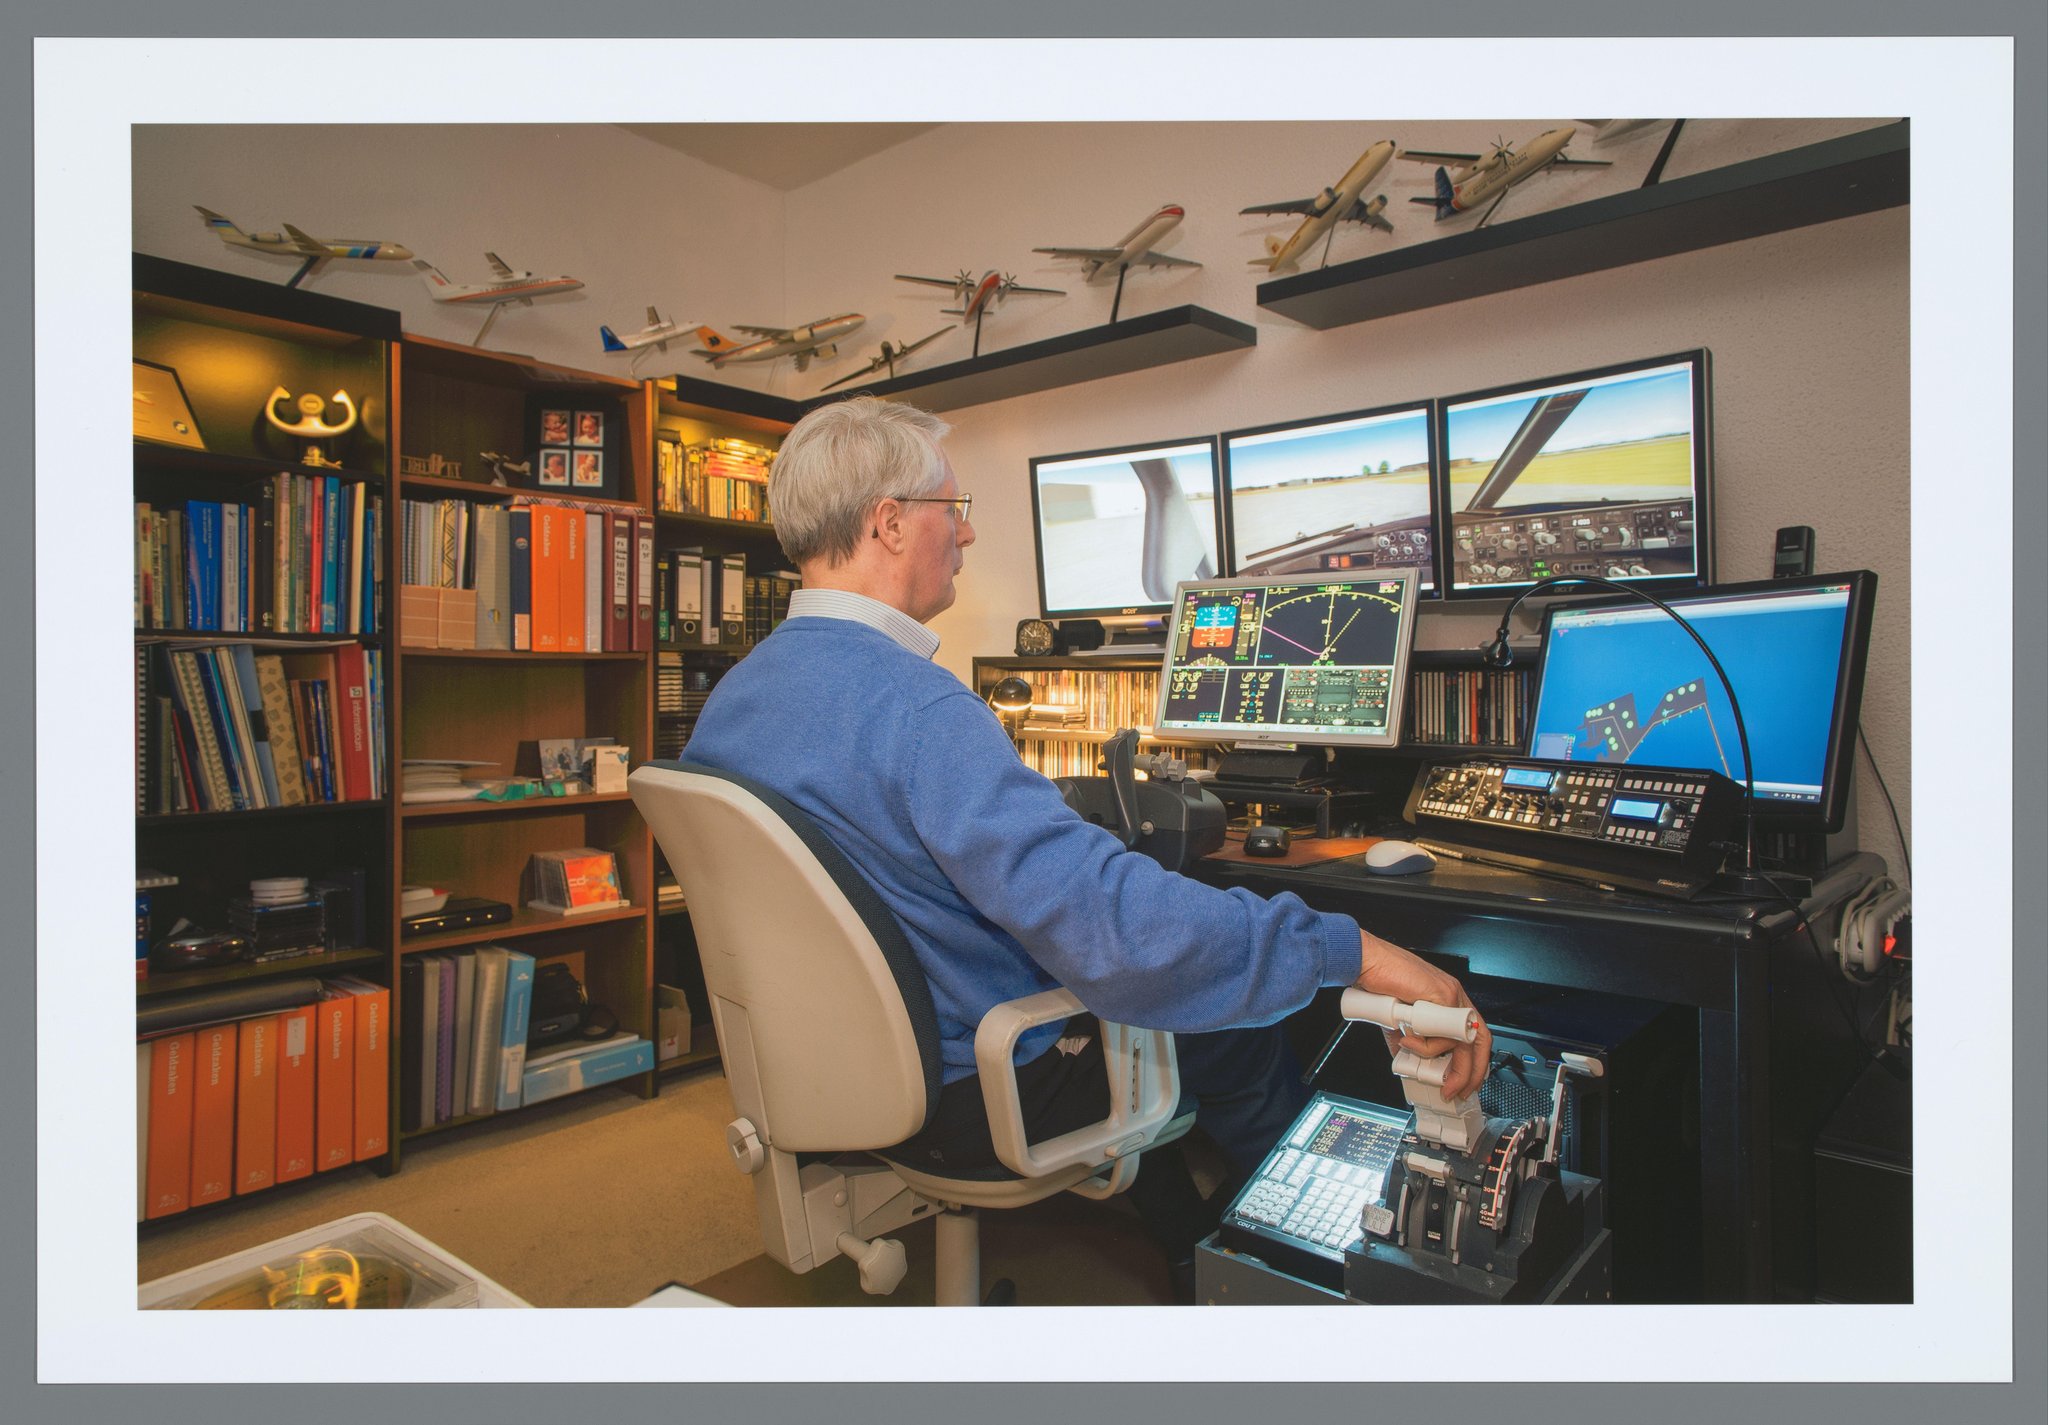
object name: photograph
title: Simon (74)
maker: gerrit meerman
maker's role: fotograaf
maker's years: 1957-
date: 2015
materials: ink, paper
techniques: inkjet print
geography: netherlands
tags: airborne traffic, aviation, computer, equation-solving machine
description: “Mijn vrouw vindt het heel leuk, zolang het maar niet in de woonkamer komt”. Simon heeft in 1961 aan de Luchtvaart Nijverheidsschool (tegenwoordig MTS Luchtvaart) zijn diploma voor vliegtuigmonteur behaald. Hij heeft veel verschillende functies in het buitenland vervuld: van monteur tot vliegtuigonderhoudsadviseur bij onder andere Schreiner BEA Helikopters, Fokker en KLM. In 1984 is Simon met Flight Simulator begonnen. Gemiddeld drie volle dagen per week is hij met zijn hobby bezig. Maandelijks traint hij in de simulator van ProSim4U en soms in de full motion van Schiphol. Op het moment is hij druk bezig met het voorbereiden van een cursus over het vliegen met de Boeing 737 voor de leden van HCC Haaglanden.